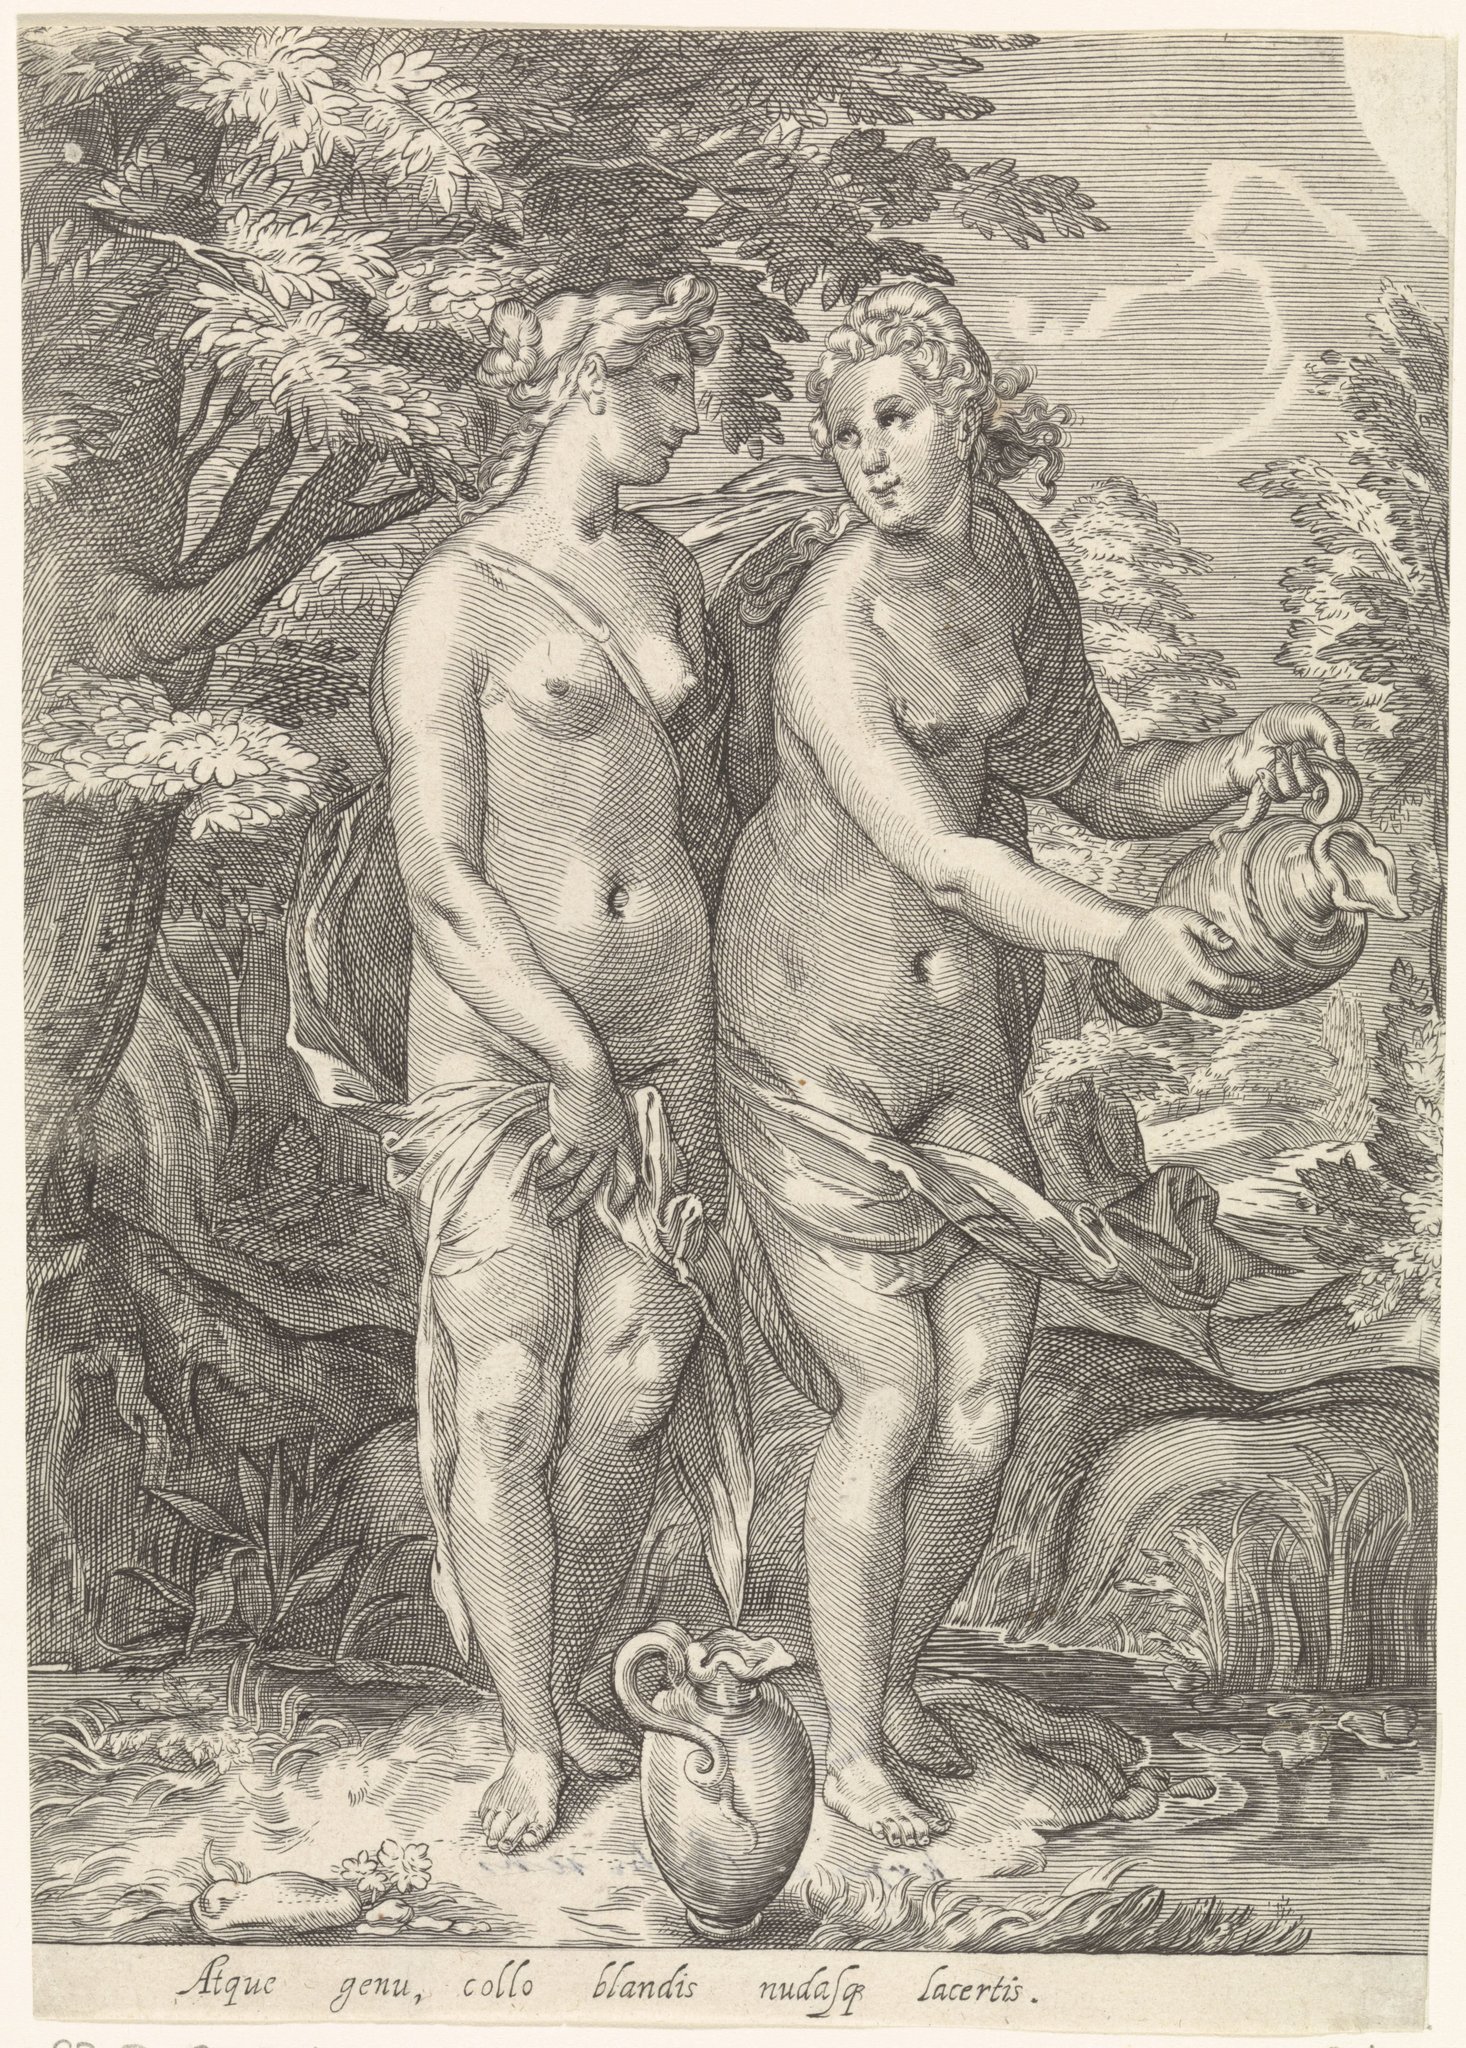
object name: print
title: Diana en haar nimfen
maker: Anonymous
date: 1616-1666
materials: paper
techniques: engraving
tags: companions, nymphs of diana; 'ninfe di diana' (ripa), brook, container of ceramics: jar, jug, pot, vase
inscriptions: collector's mark: Lugt 2228, caption: ‘Kopie in contrasens’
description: Twee nimfen uit het gevolg van Diana. Ze staan naast een beekje. Een van de nimfen giet haar waterkruik leeg in de beek. De prent heeft een Latijns onderschrift.